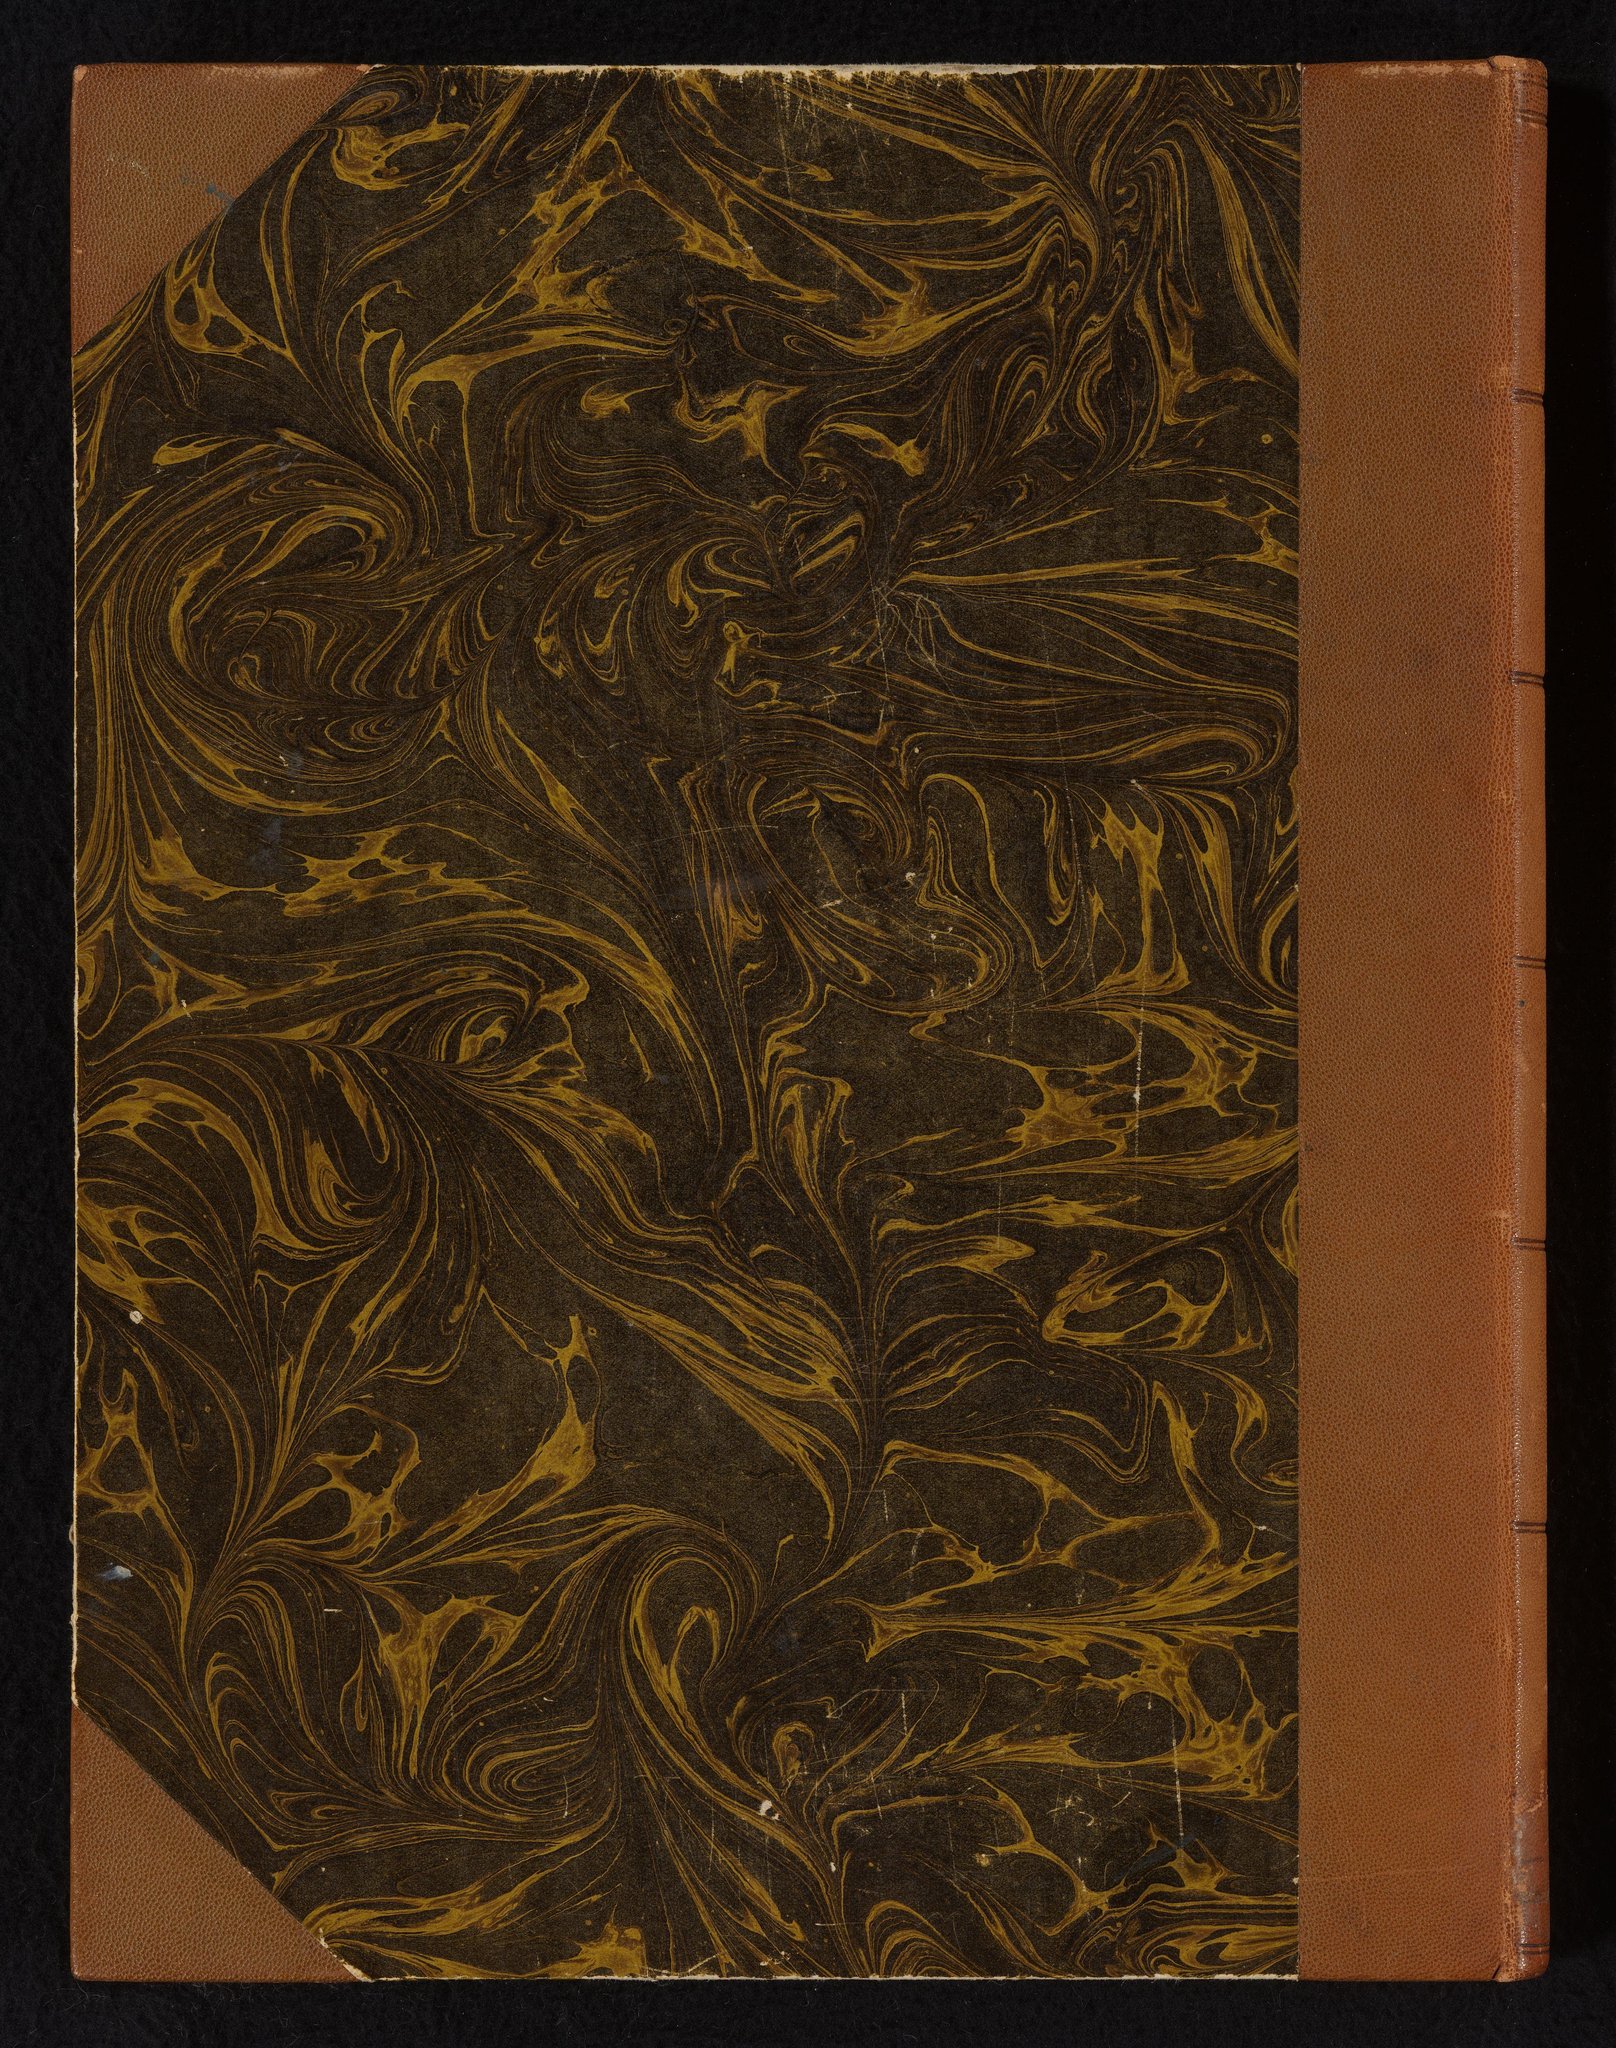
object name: book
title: Prentenalbum van Bunrei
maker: maekawa bunrei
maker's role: print maker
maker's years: 1837-1917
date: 1885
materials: paper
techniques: woodcut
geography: yokohama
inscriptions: label: ‘C.J. Mensing. Boekbinder Amsterdam’